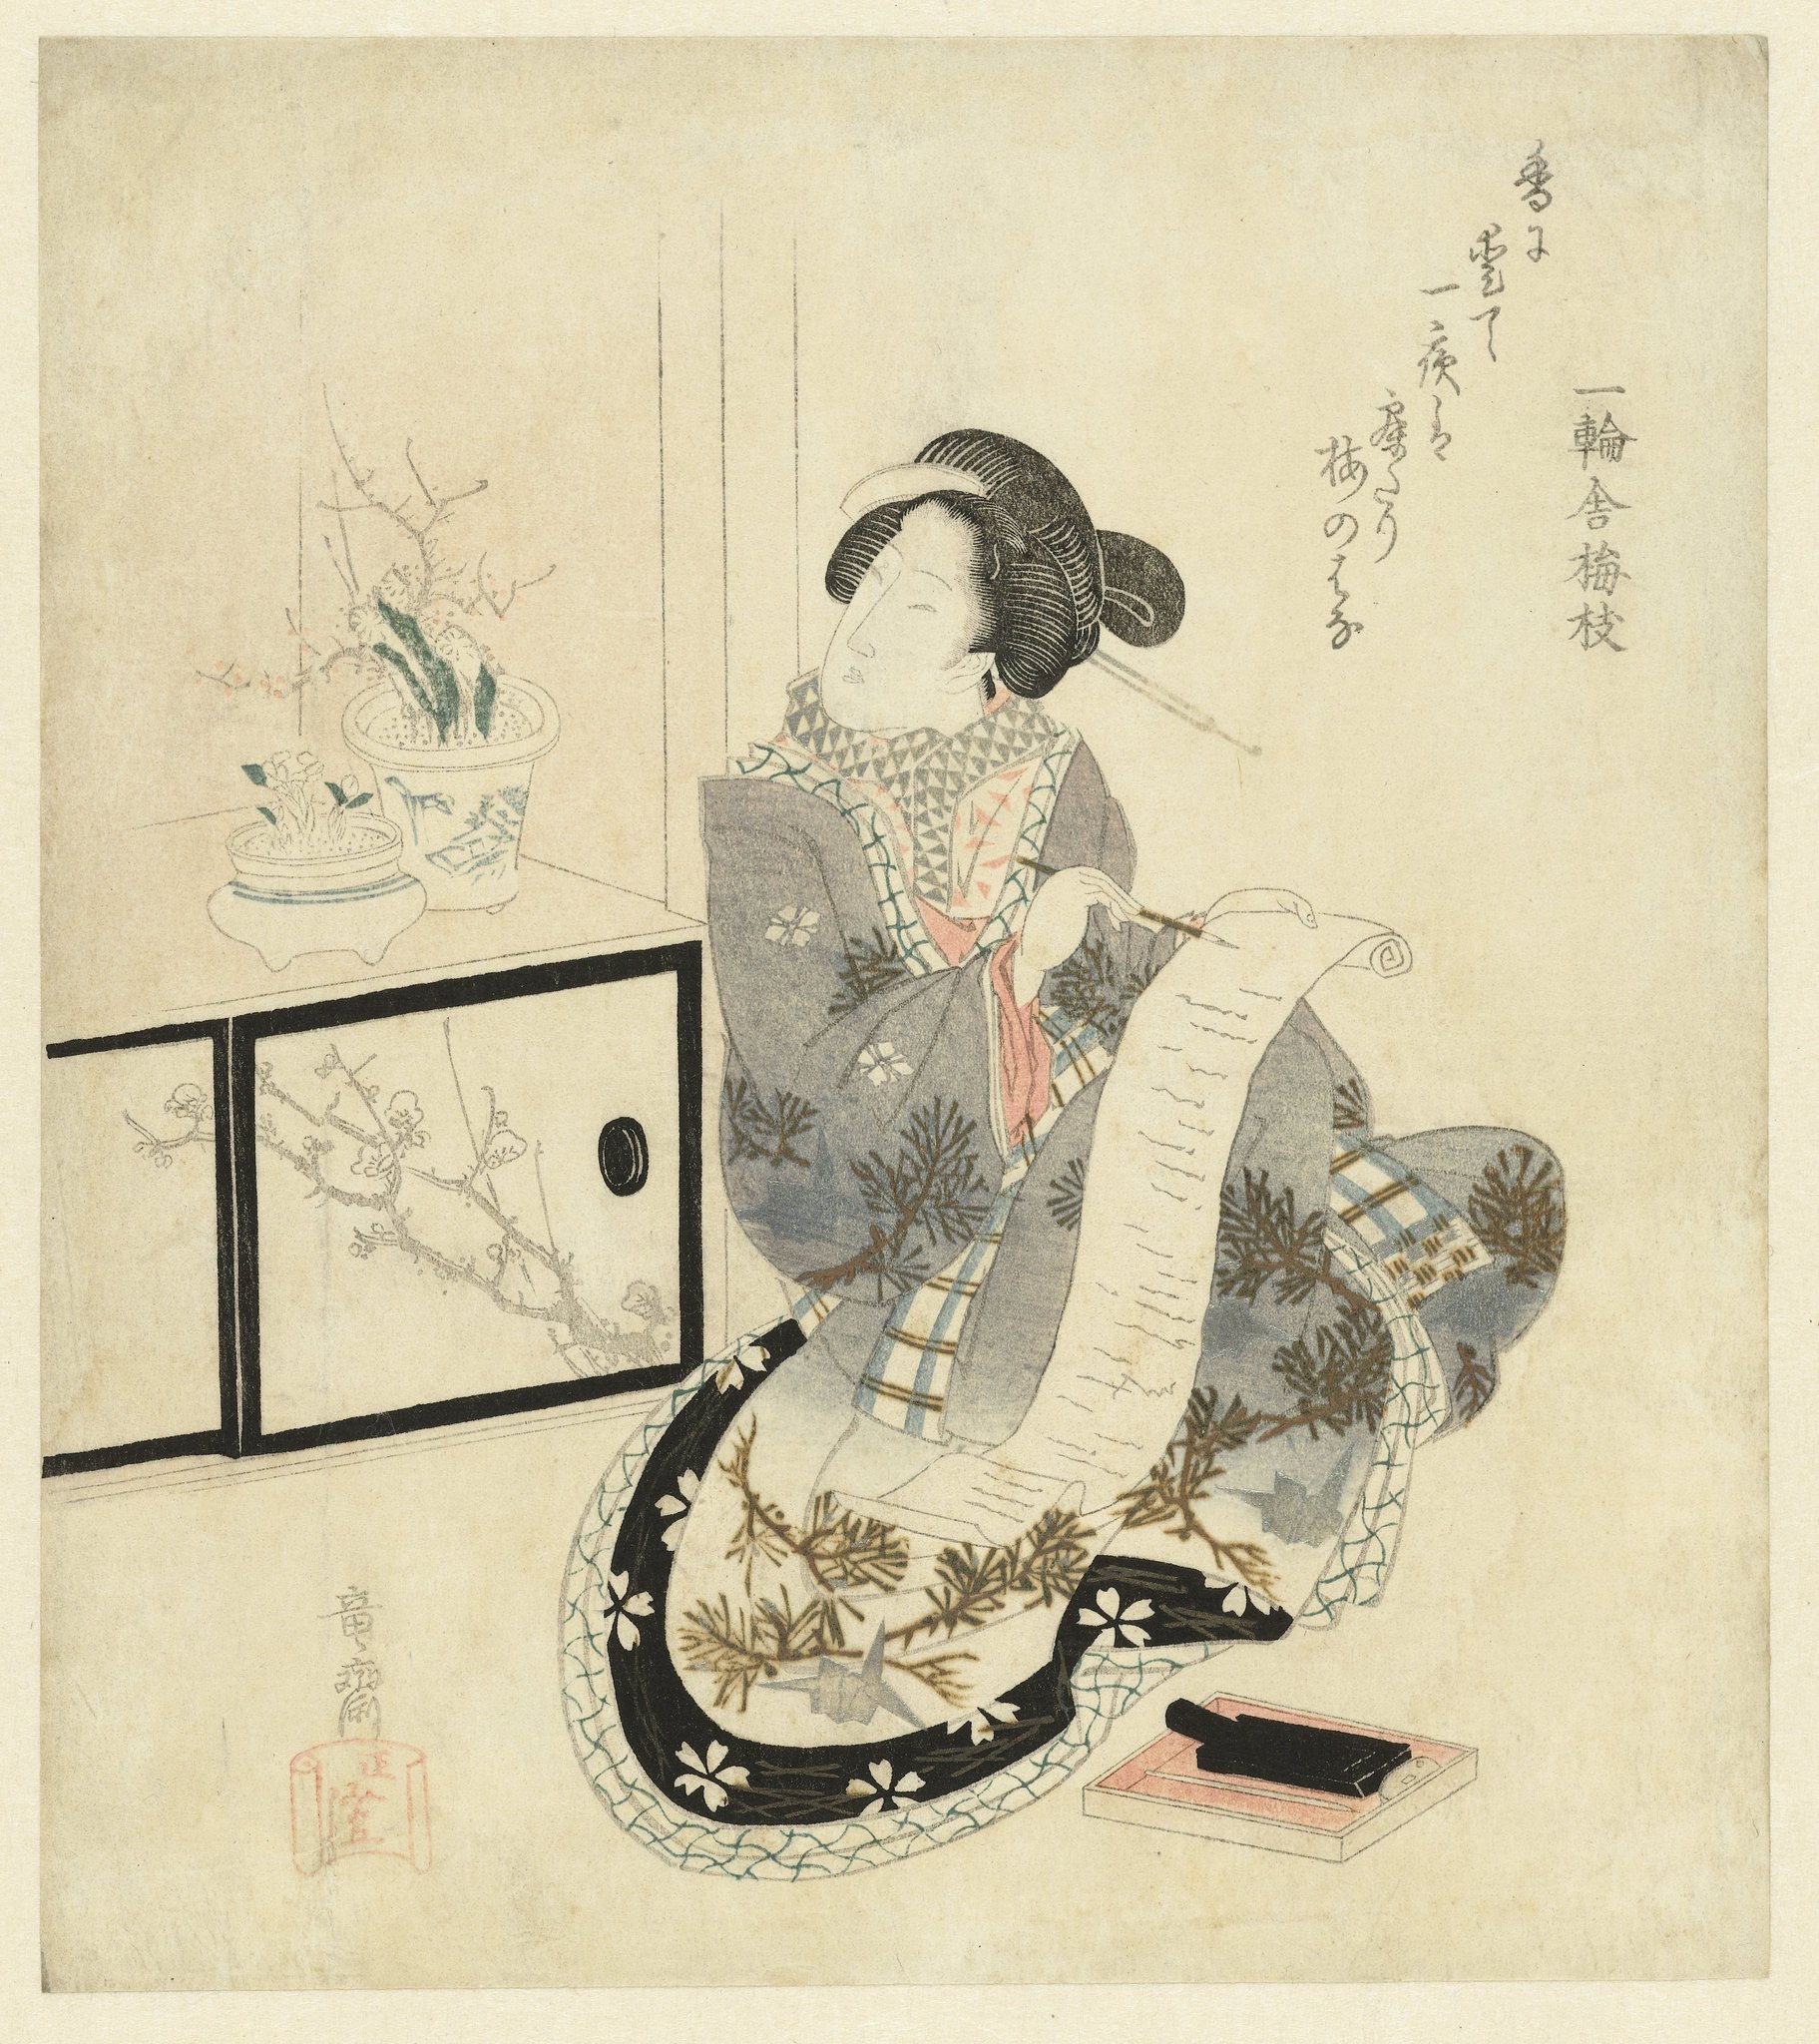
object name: surimono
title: Woman Writing a Letter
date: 1821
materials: paper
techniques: blind stamped, woodcut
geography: japan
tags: sitting figure - aa - female human figure, interior of the house, writing and letters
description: Een surimono is een luxe uitgevoerde prent waarop beeld met één of meerdere gedichten gecombineerd is. Bij het drukken van een surimono werd vaak gebruik gemaakt van dikker papier, blinddruk en metaal pigmenten, zoals koper- en zilverpoeder. De prenten werden vaak in opdracht van dichters gemaakt en als exclusief geschenk aan vrienden en relaties gegeven.